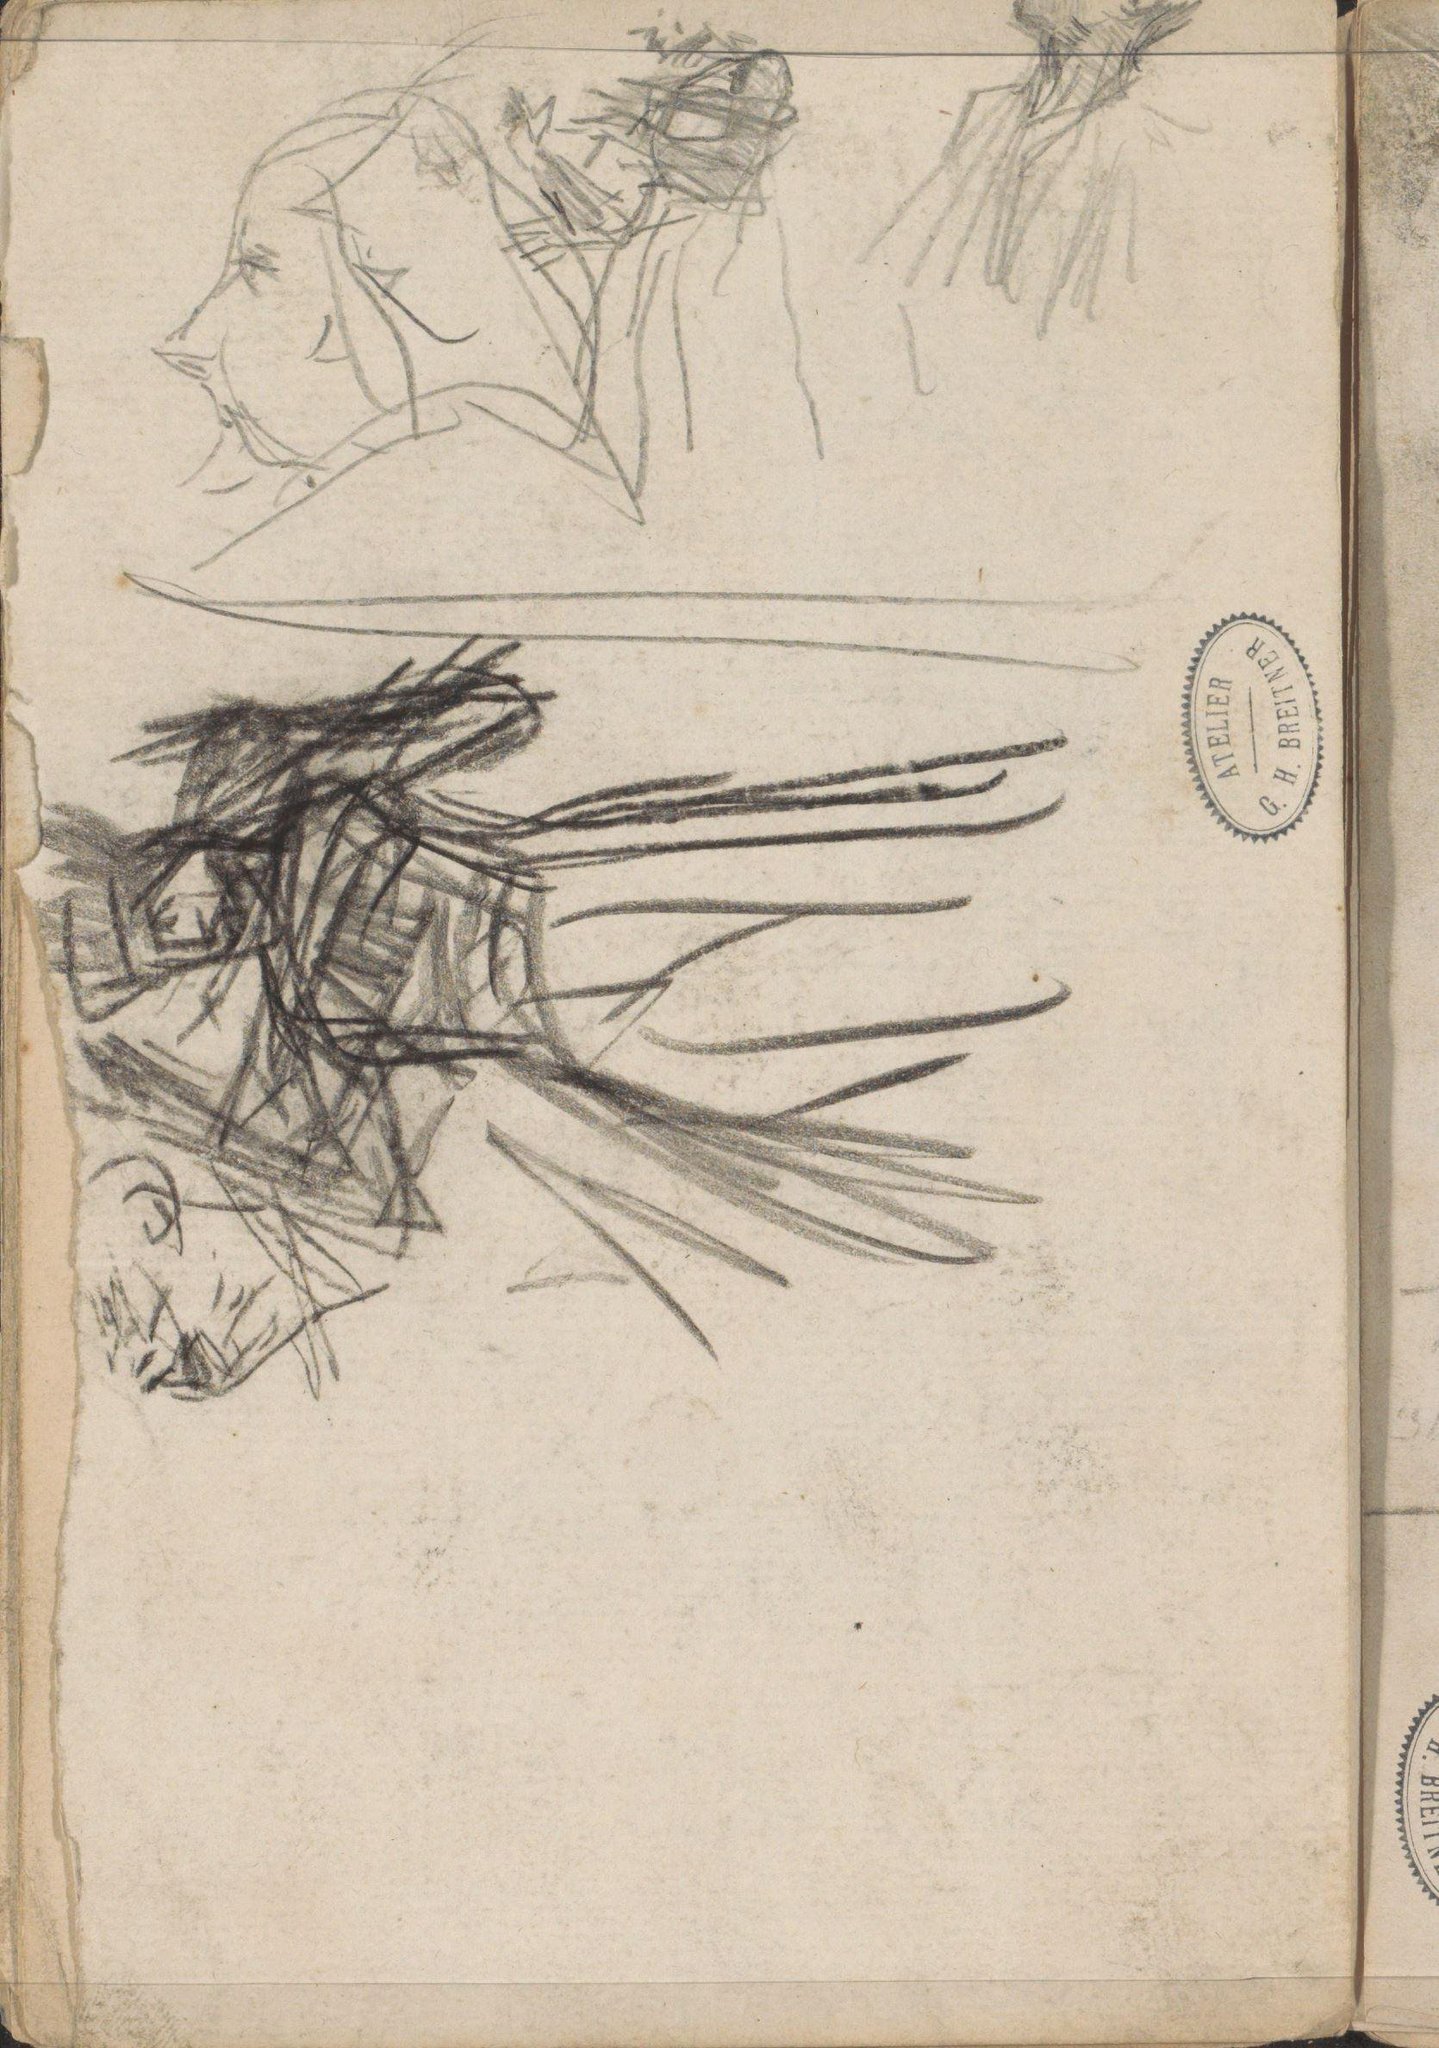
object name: sketchbook leaf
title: Figuurstudies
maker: george hendrik breitner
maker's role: draughtsman, painter, print maker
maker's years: 1857-1923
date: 1886-1923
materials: chalk, paper, pencil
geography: amsterdam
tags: adult woman, adult man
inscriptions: workshop stamp: Lugt 291d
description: Pagina 25 uit een schetsboek met 19 bladen en 9 losse tekeningen.